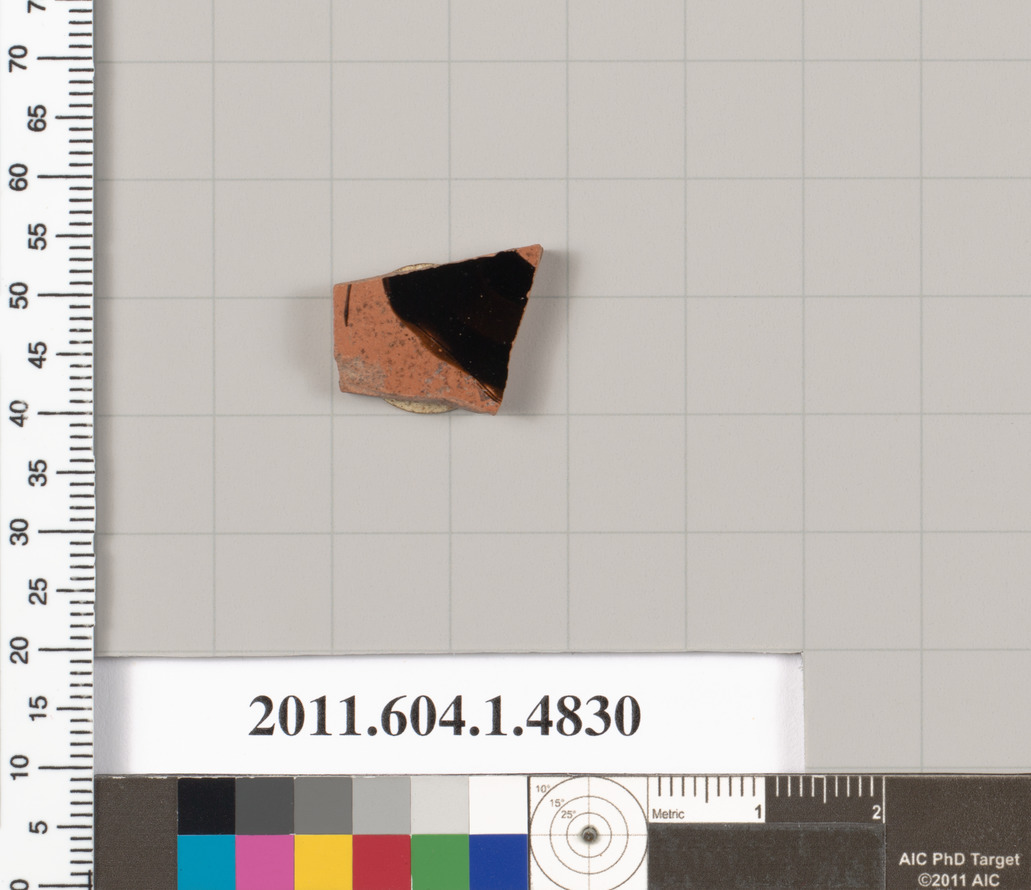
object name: kylix fragment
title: Terracotta fragment of a kylix (drinking cup)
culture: greek, attic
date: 490-470 BCE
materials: terracotta